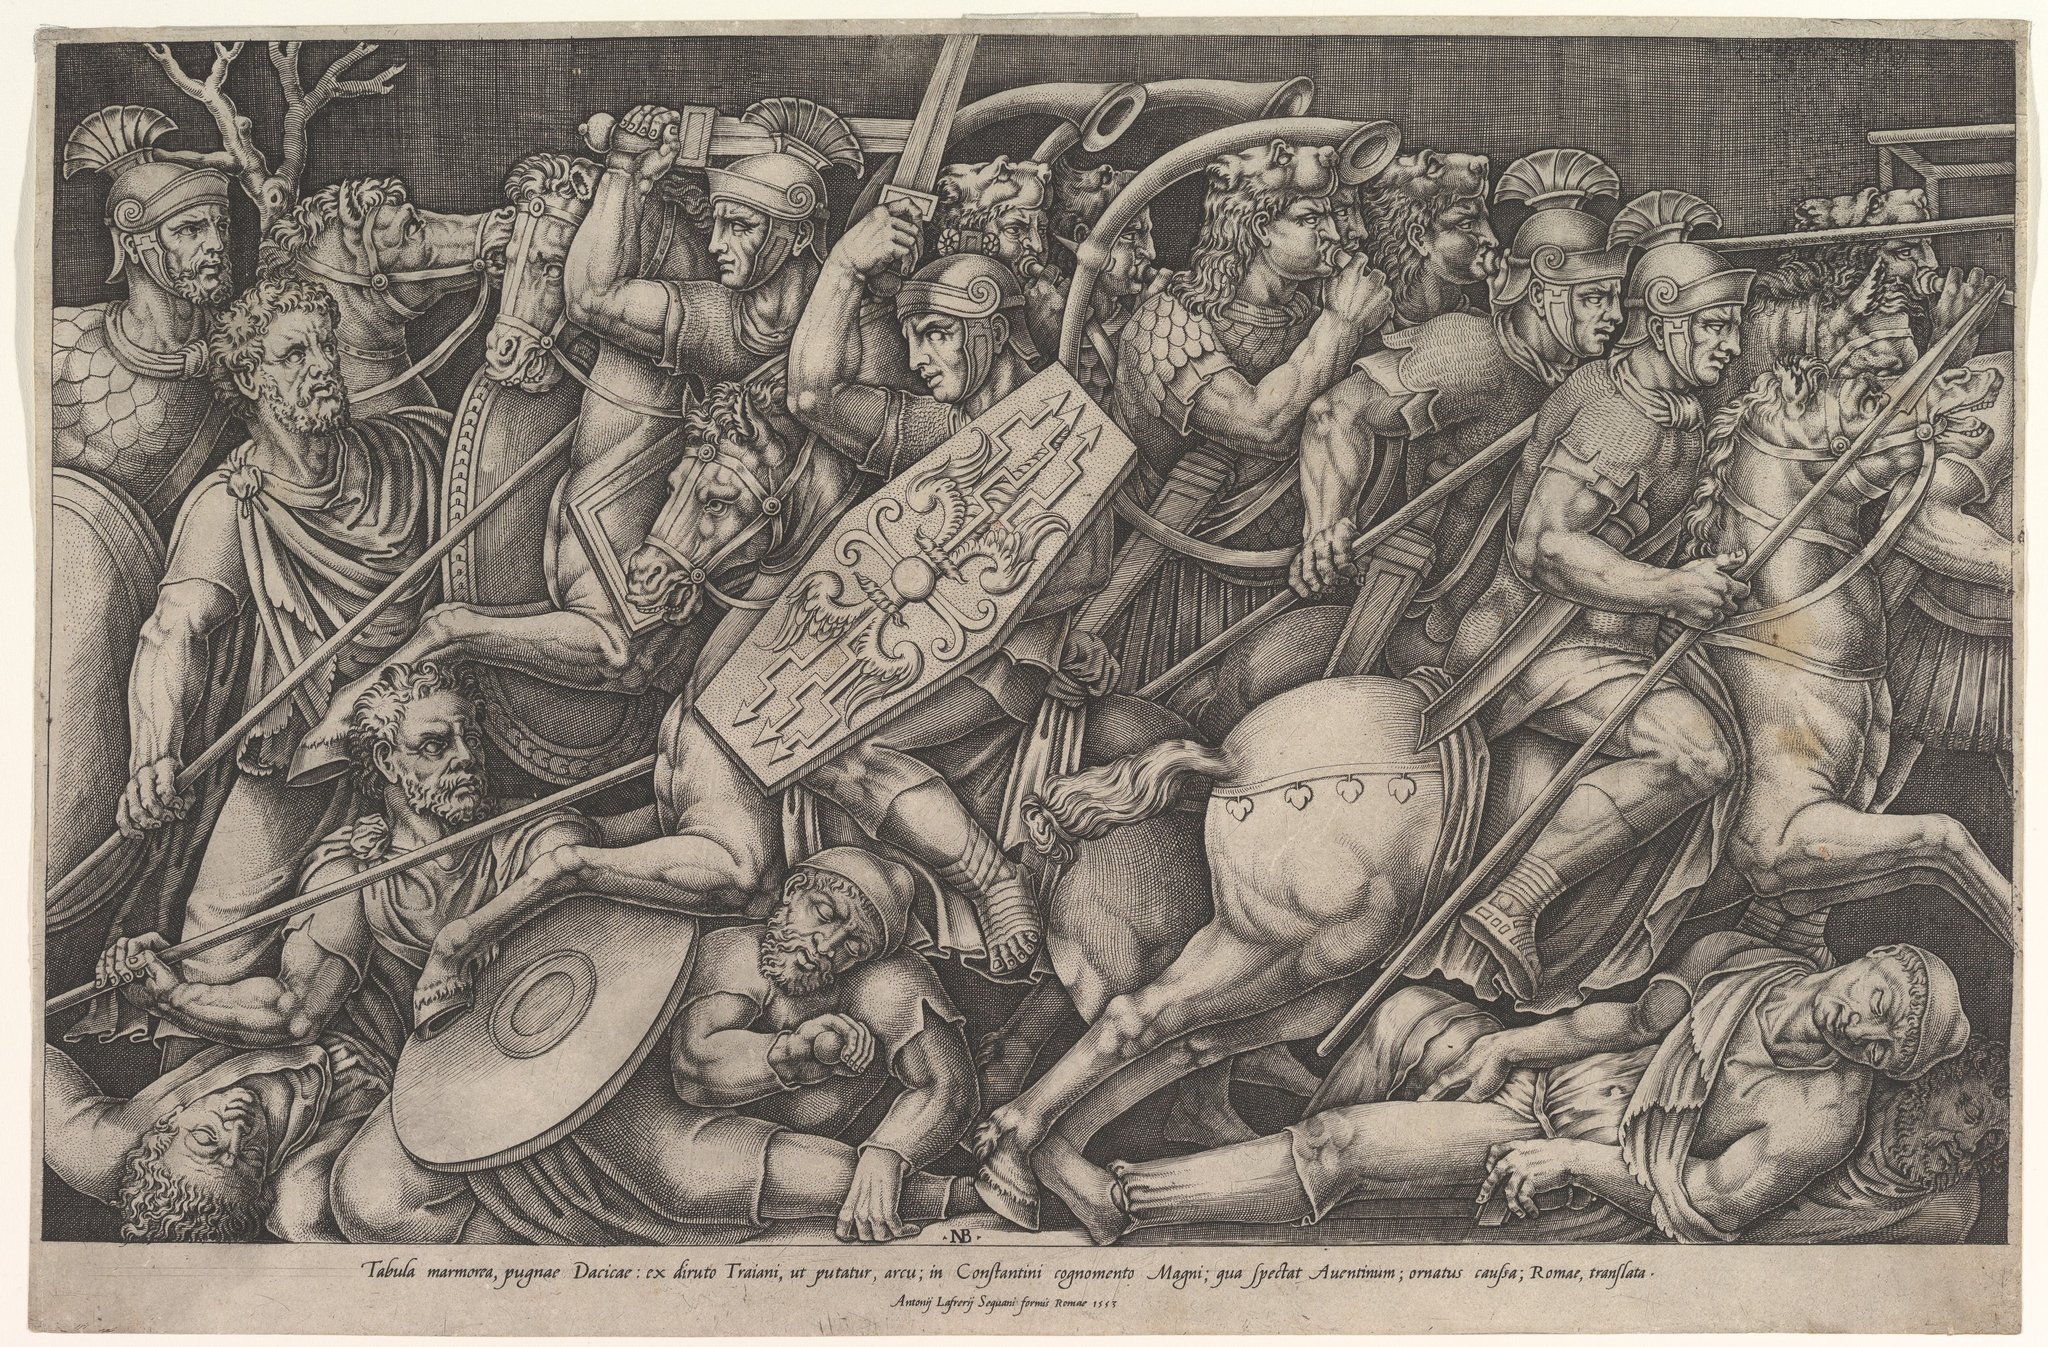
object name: print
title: Roman soldiers fighting against Dacians, battle scene in shallow depth with horses and horn-players (after a bas-relief on the Arch of Constantine, Rome)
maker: nicolas beatrizet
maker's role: artist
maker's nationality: french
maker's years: 1515-1566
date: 1553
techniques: engraving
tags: musical instruments,battles,soldiers,horses